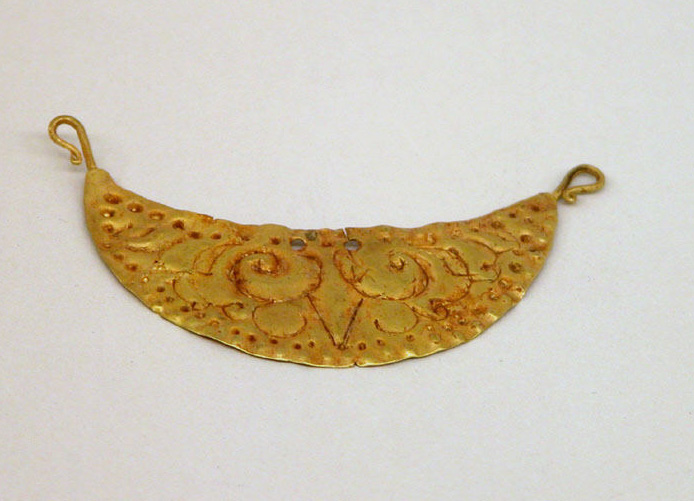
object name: pendant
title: Cresecent Moon-Shaped Pendant with Foliate Design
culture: indonesian, javanese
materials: gold